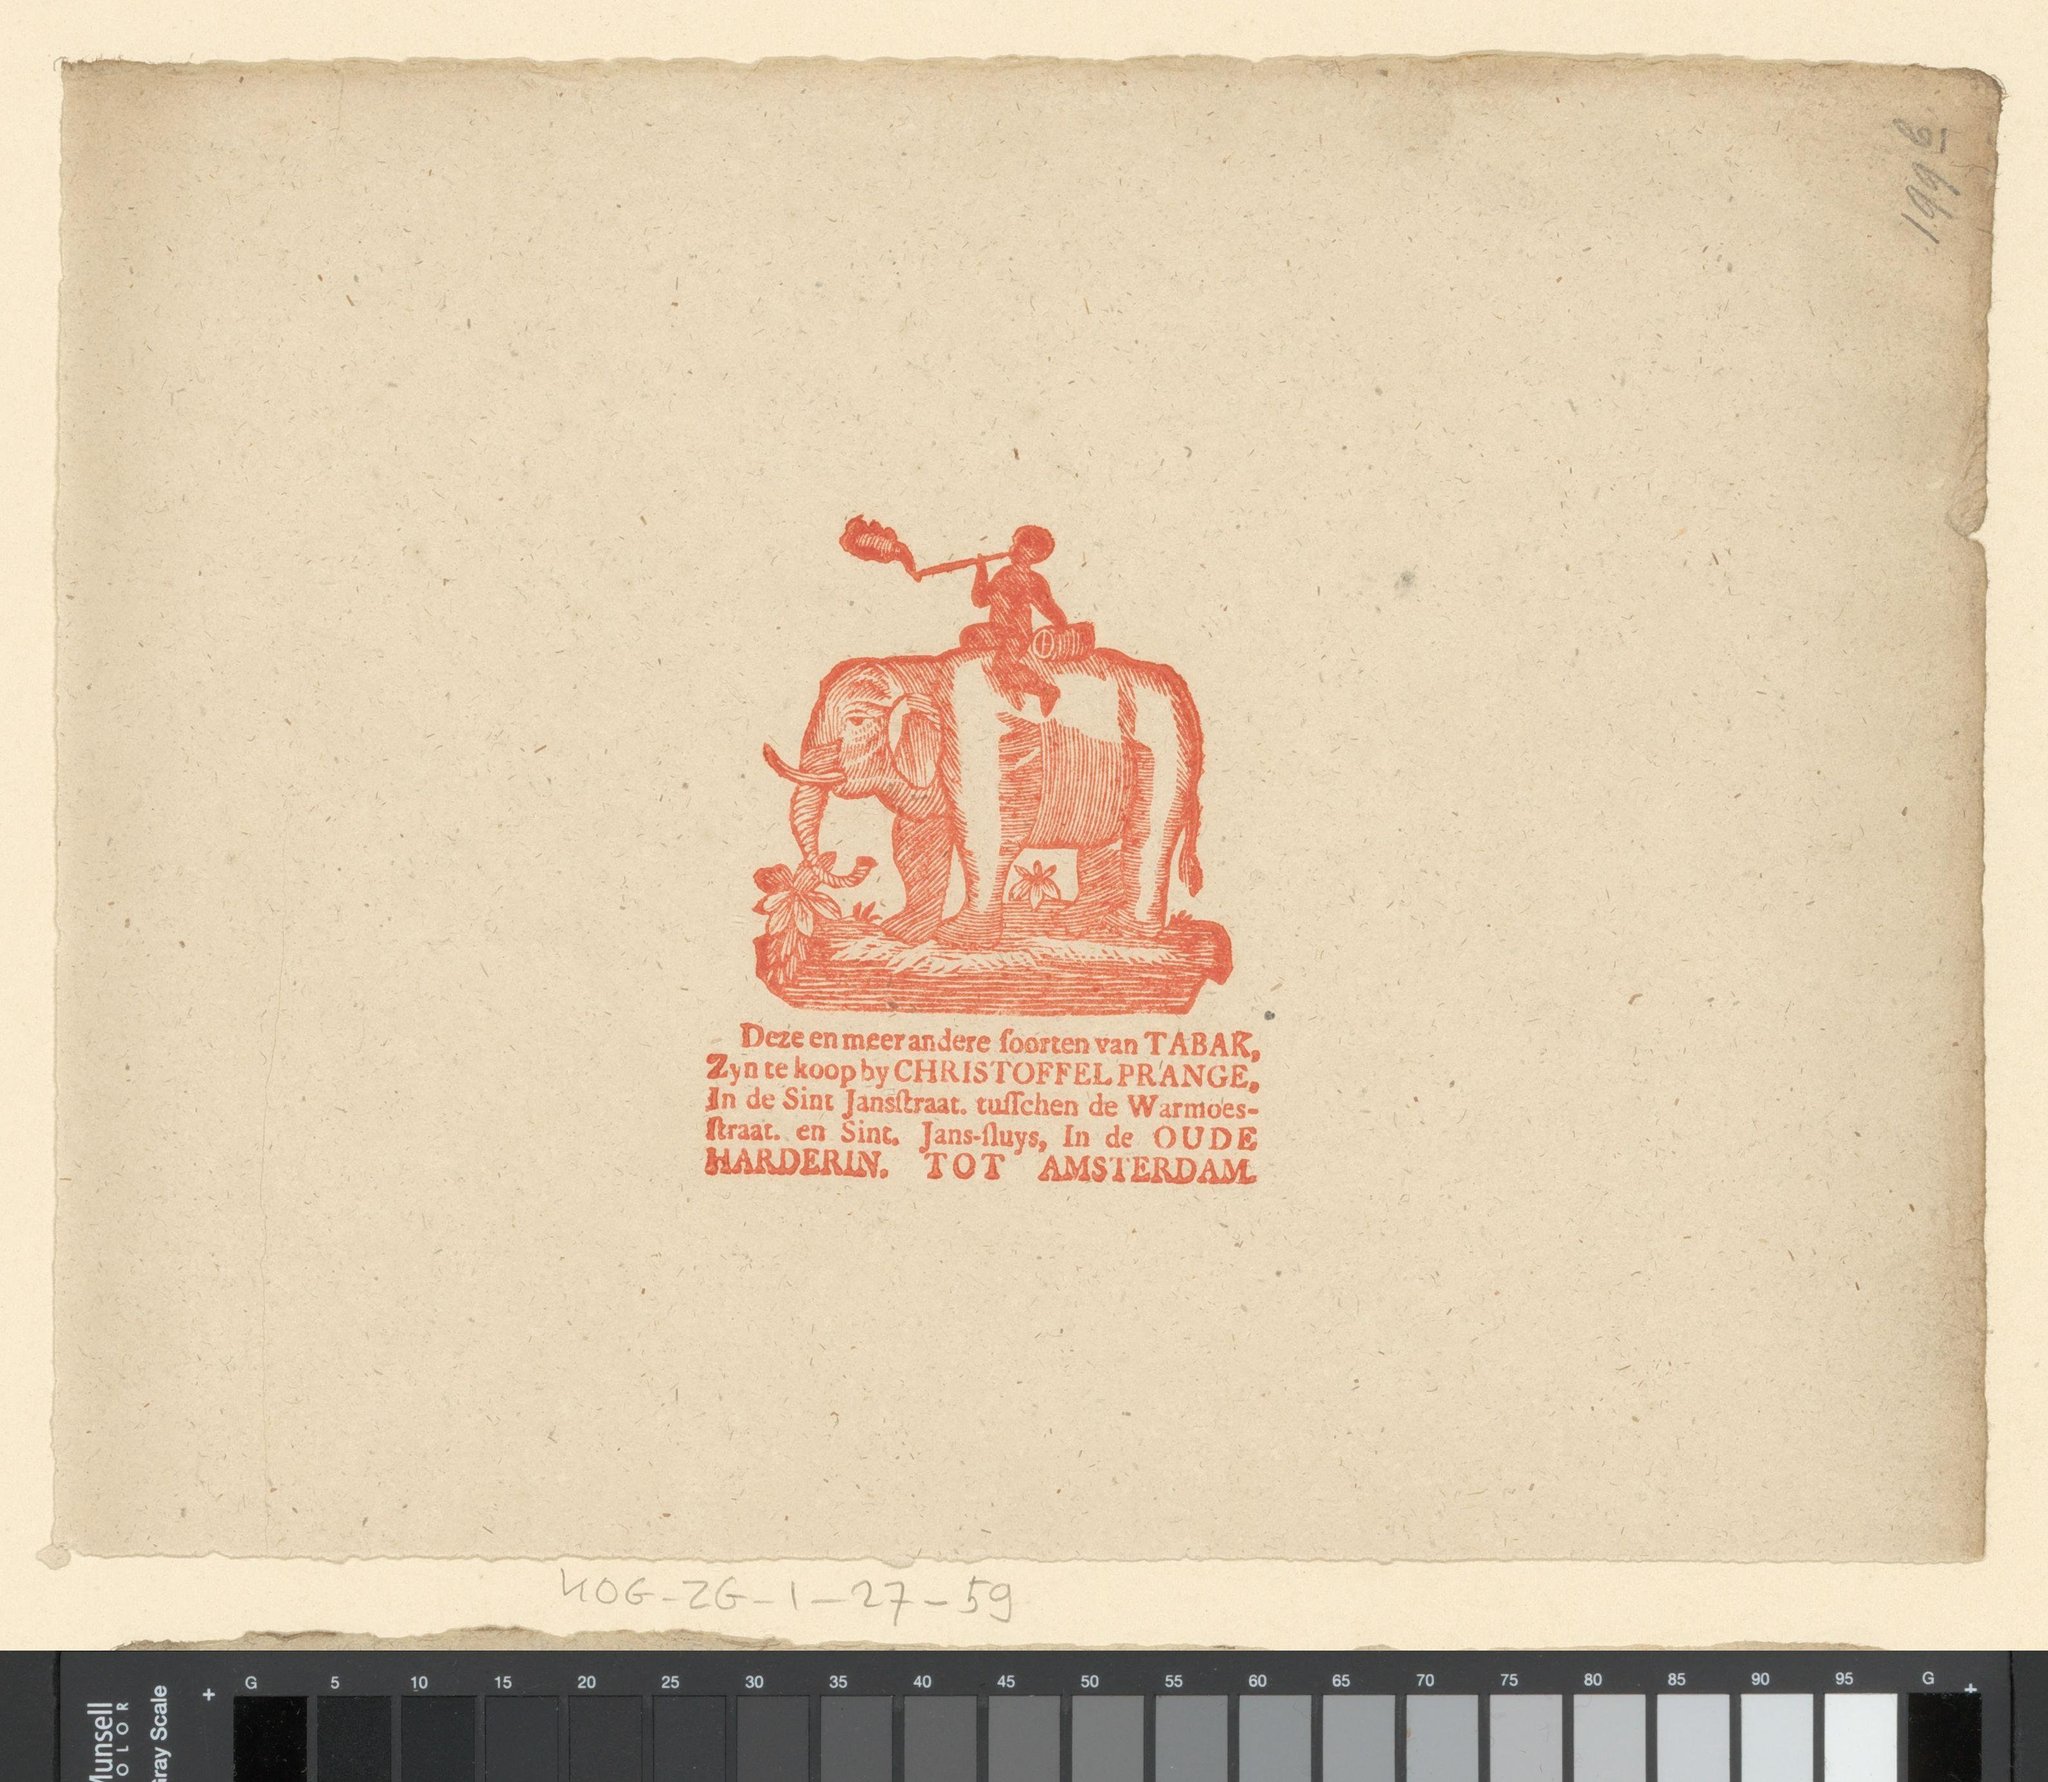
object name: print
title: Etiket voor tabaksverpakking van Christoffel Prange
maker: Anonymous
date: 1750-1790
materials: paper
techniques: letterpress printing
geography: netherlands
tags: amsterdam, pipe ~ tobacco, riding on animal other than horse, ass, or mule, trunked animals: elephant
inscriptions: collector's mark: Lugt 1641, collector's mark